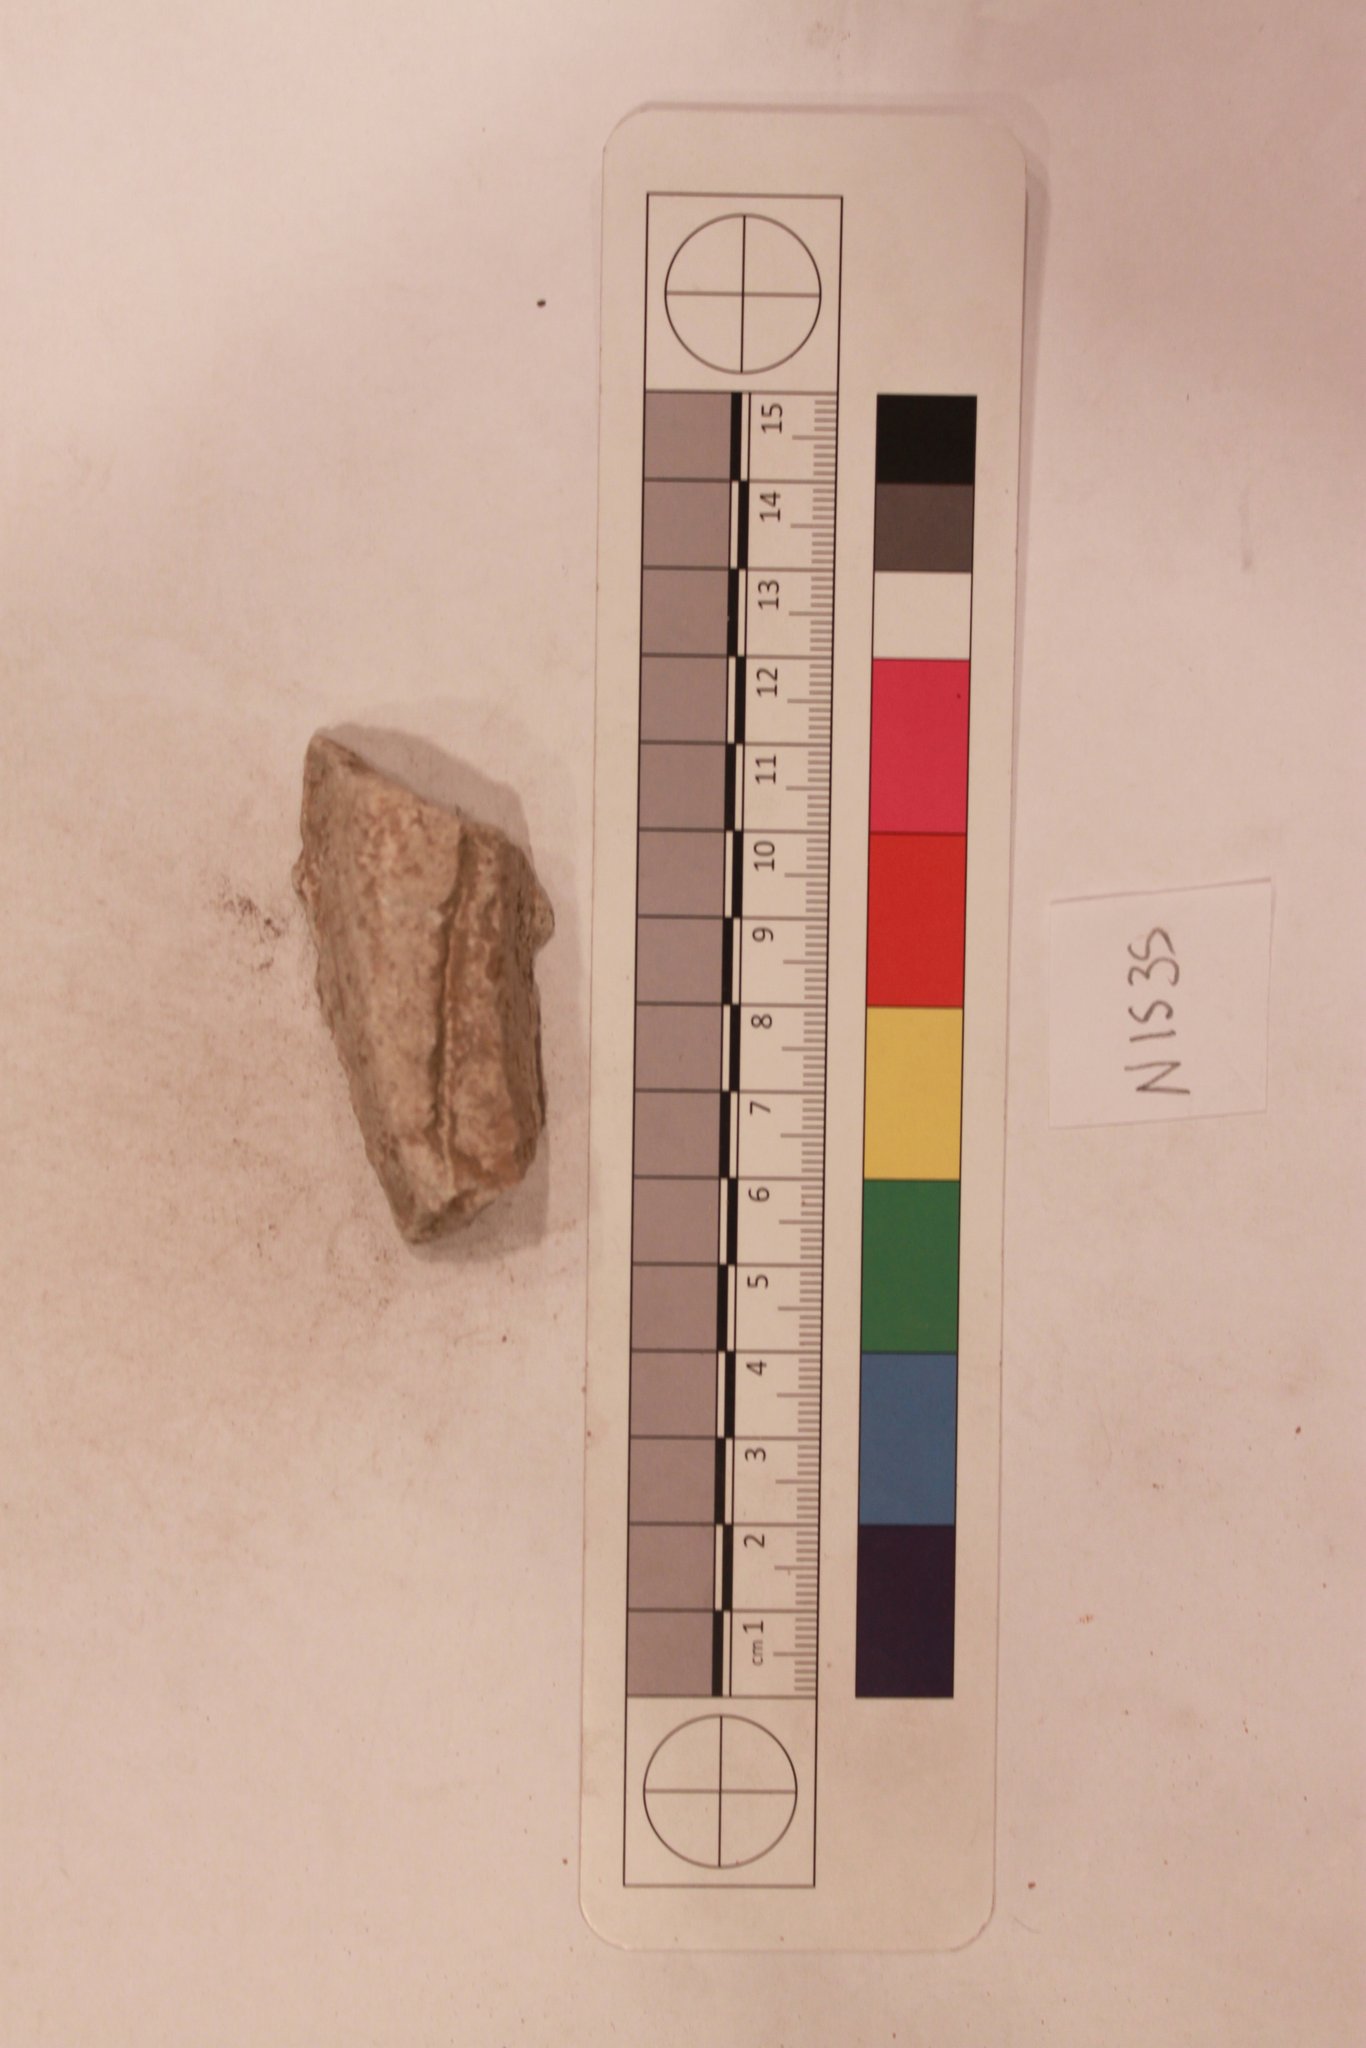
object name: fragment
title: Stucco Fragment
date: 701-1200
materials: plaster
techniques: carving, painting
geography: iran